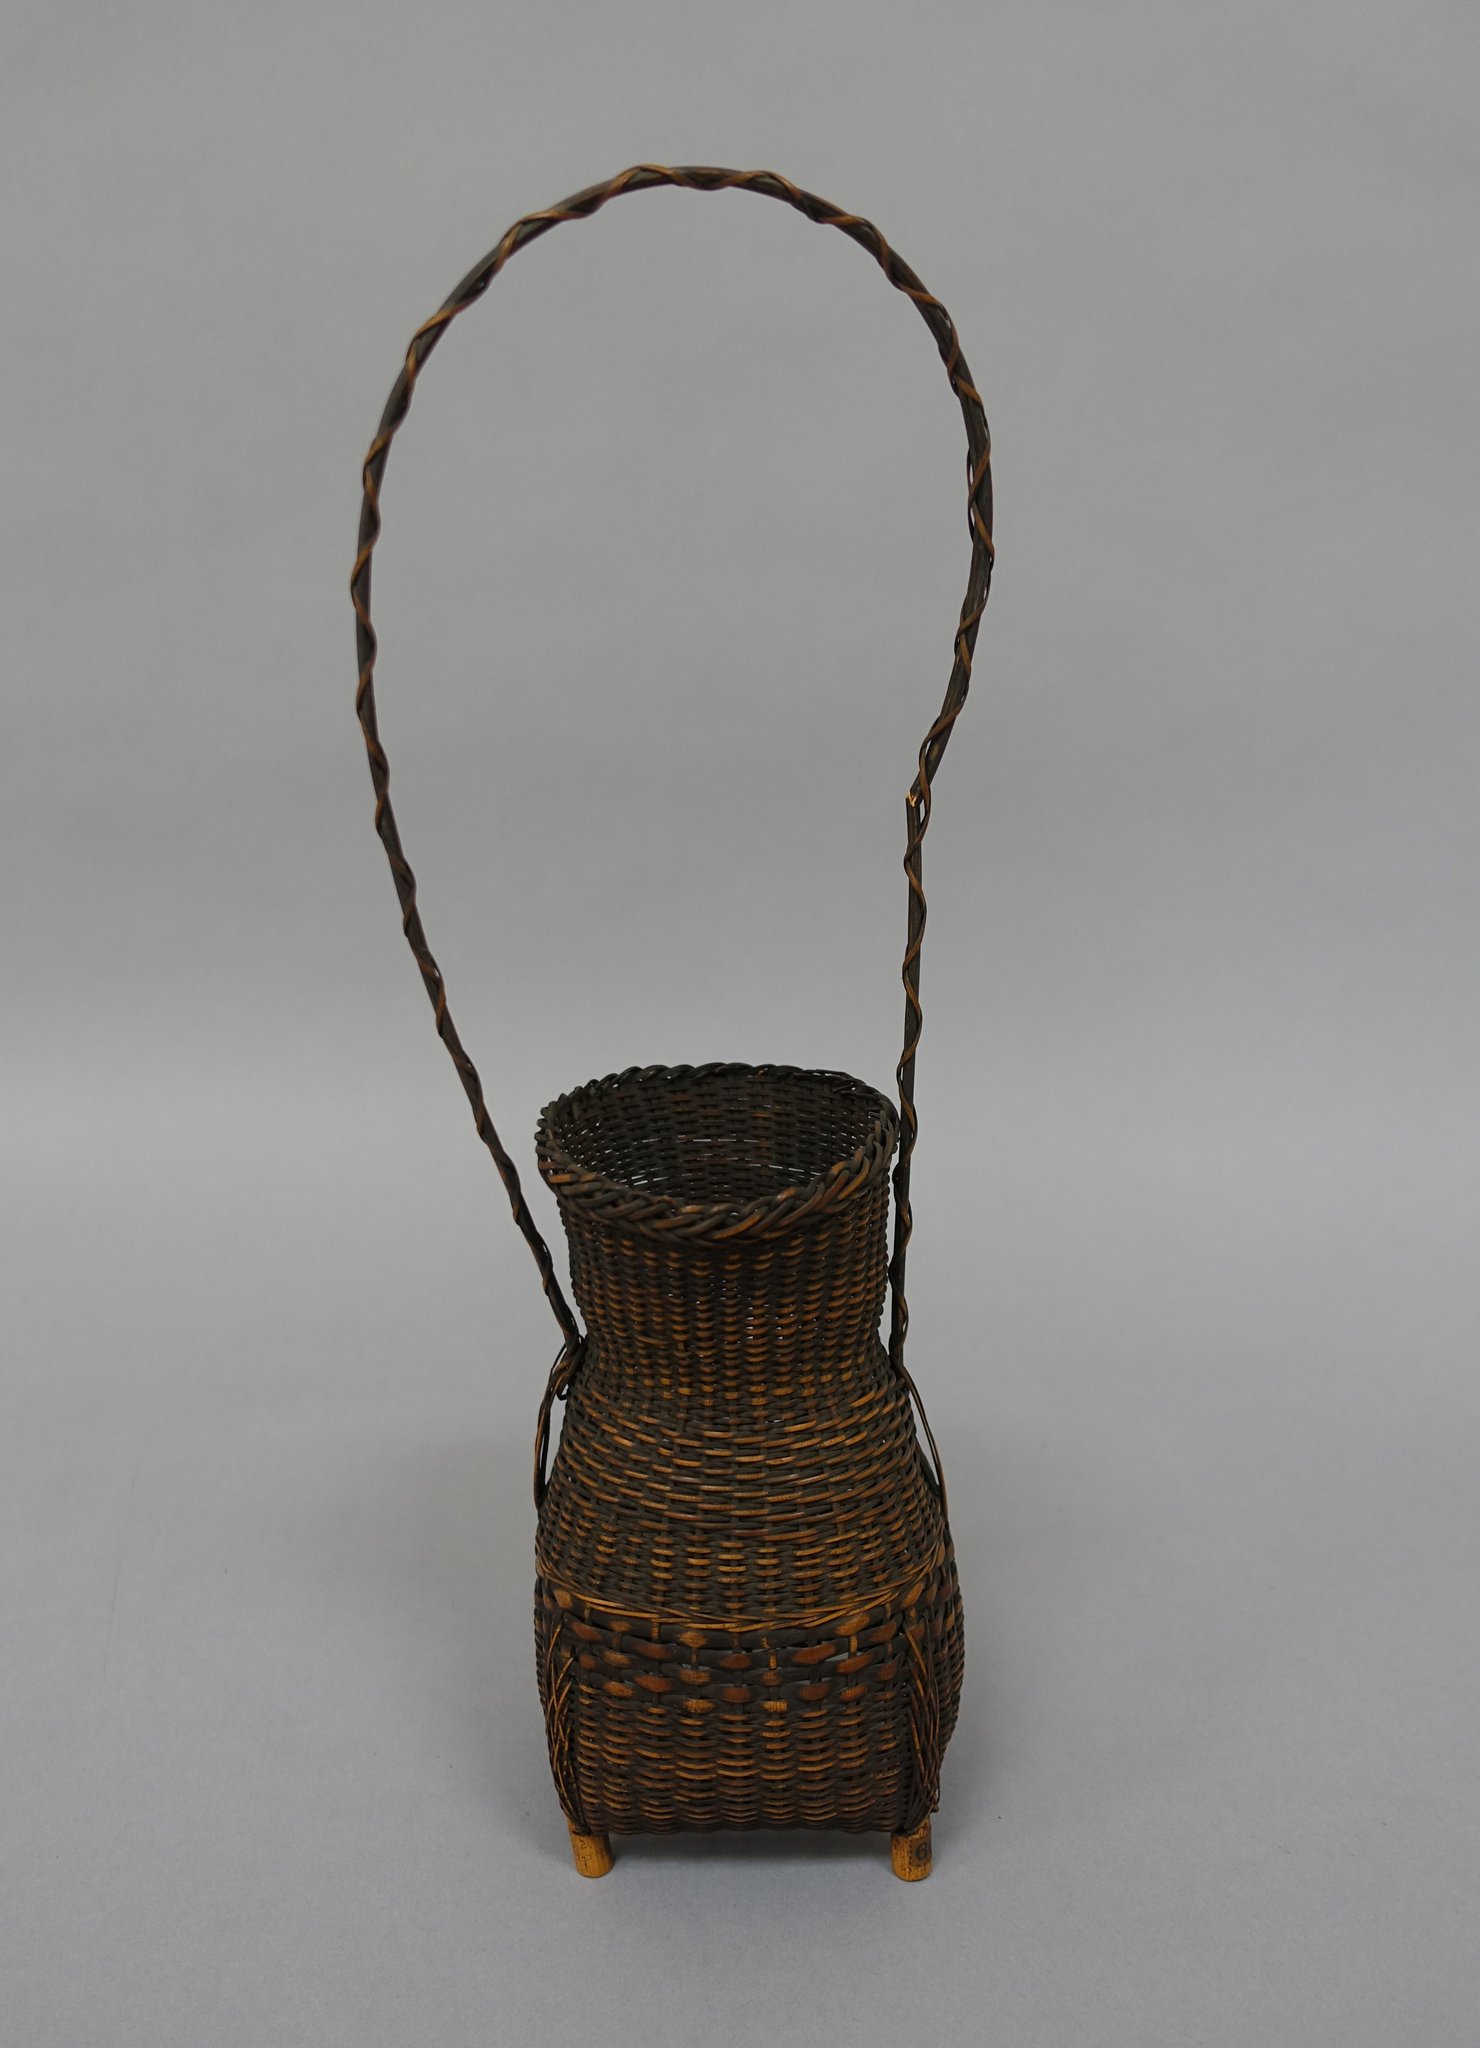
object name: basket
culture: japanese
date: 1801-1900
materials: bamboo